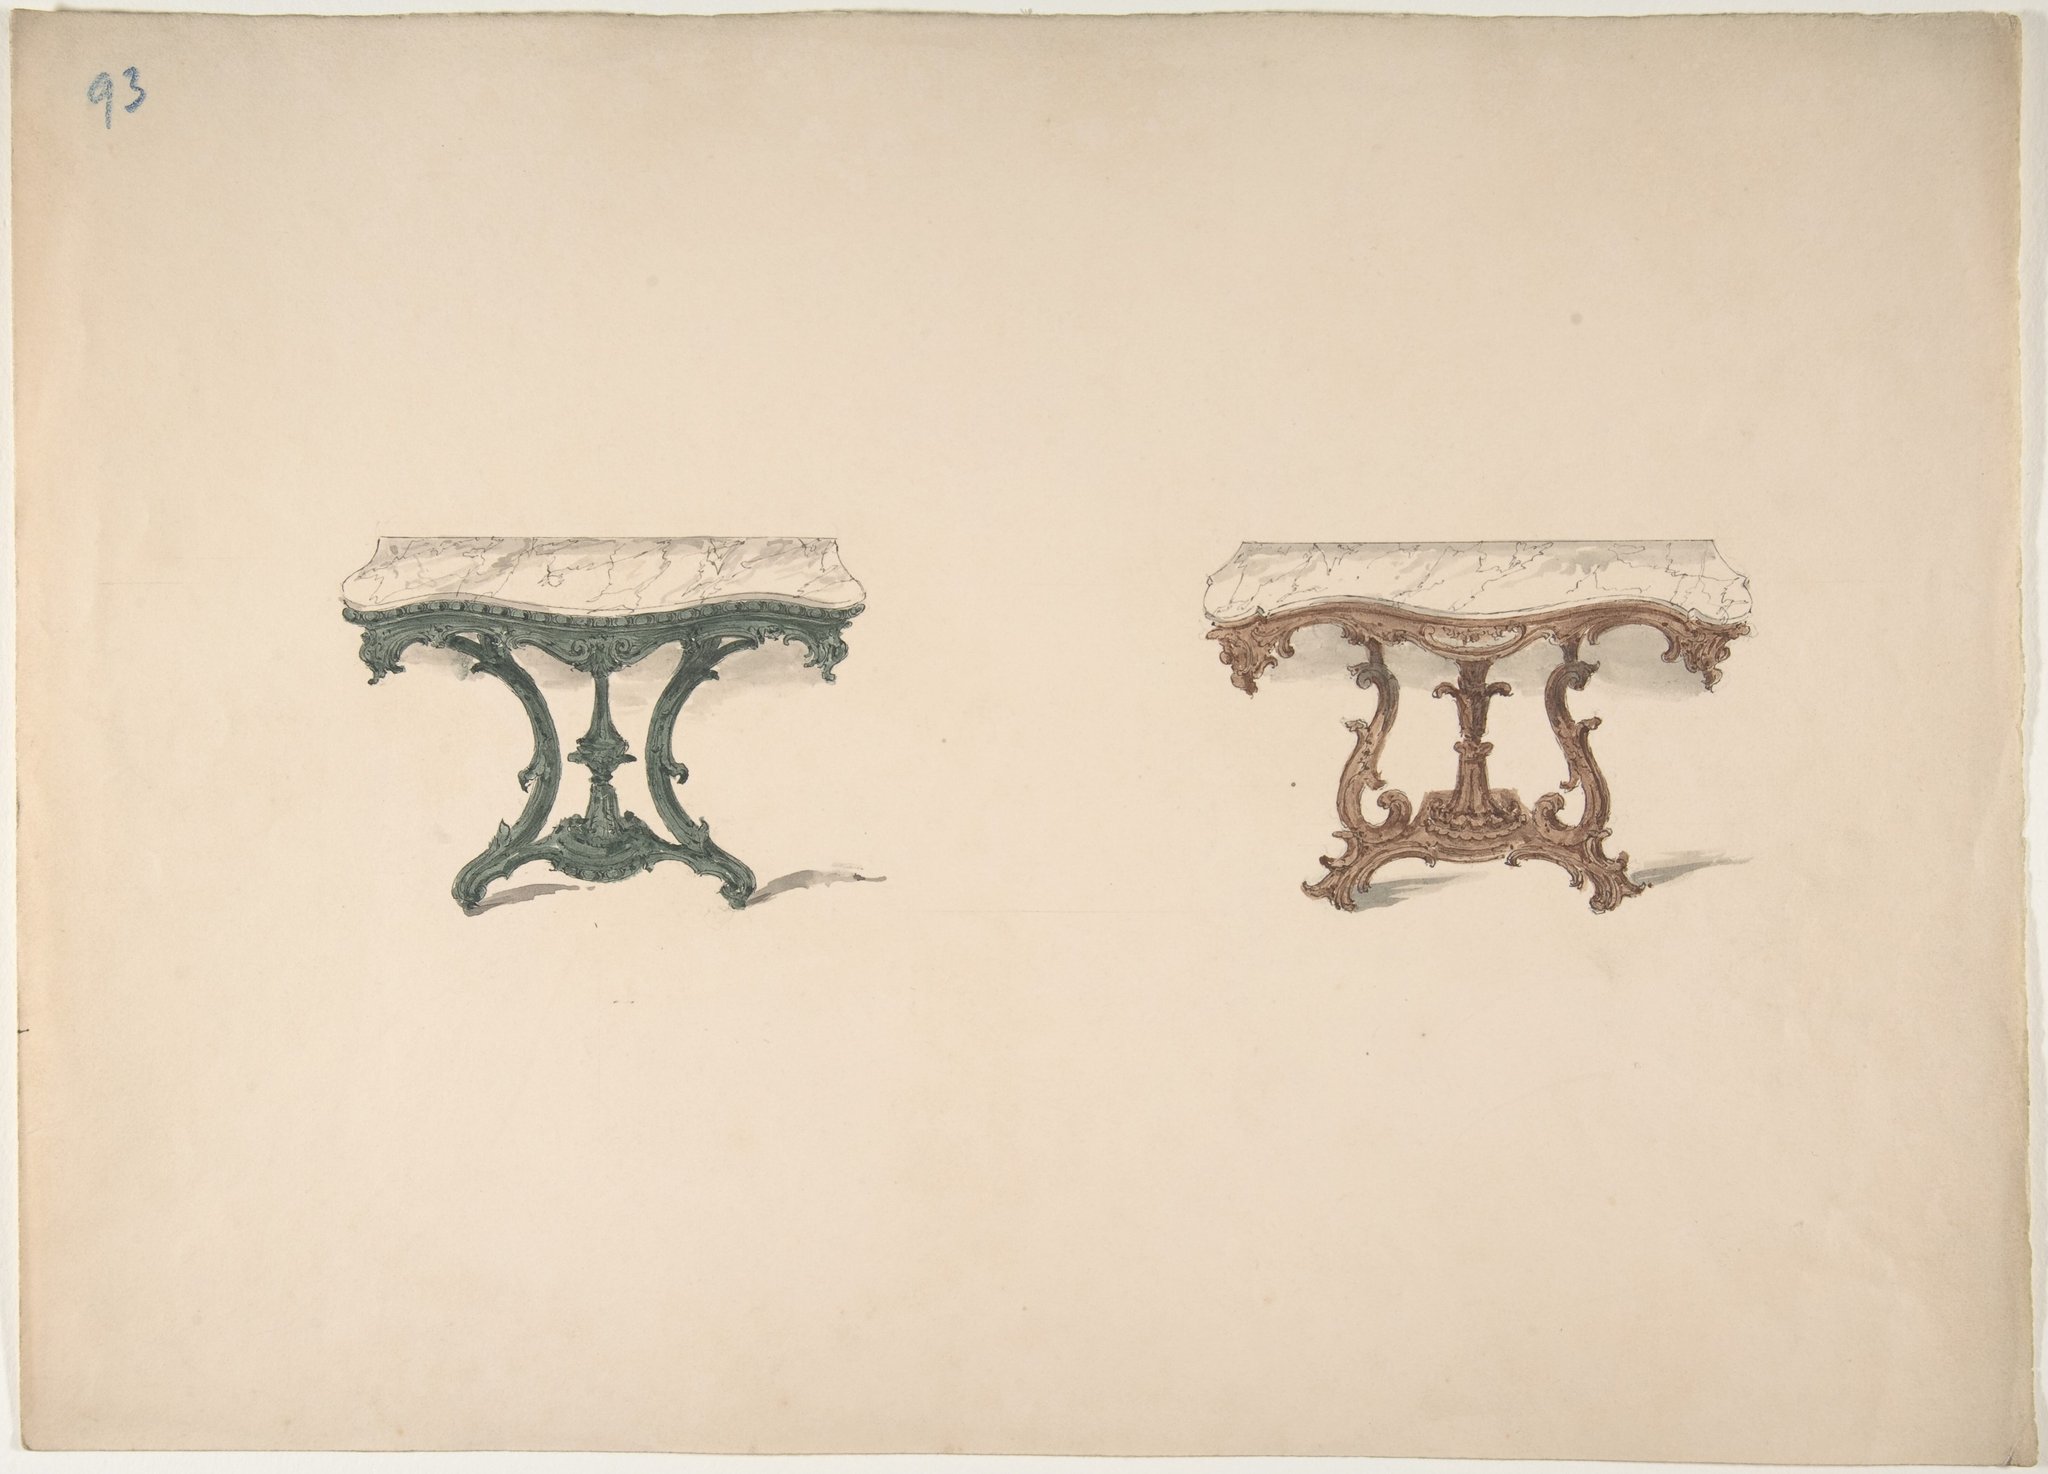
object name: drawing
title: Design for Two Marble Topped Tables with Carved Legs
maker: anonymous, british, 19th century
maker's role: artist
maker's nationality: british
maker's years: 1800-1900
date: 1801-1833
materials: ink, watercolor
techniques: brush, pen, wash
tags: tables